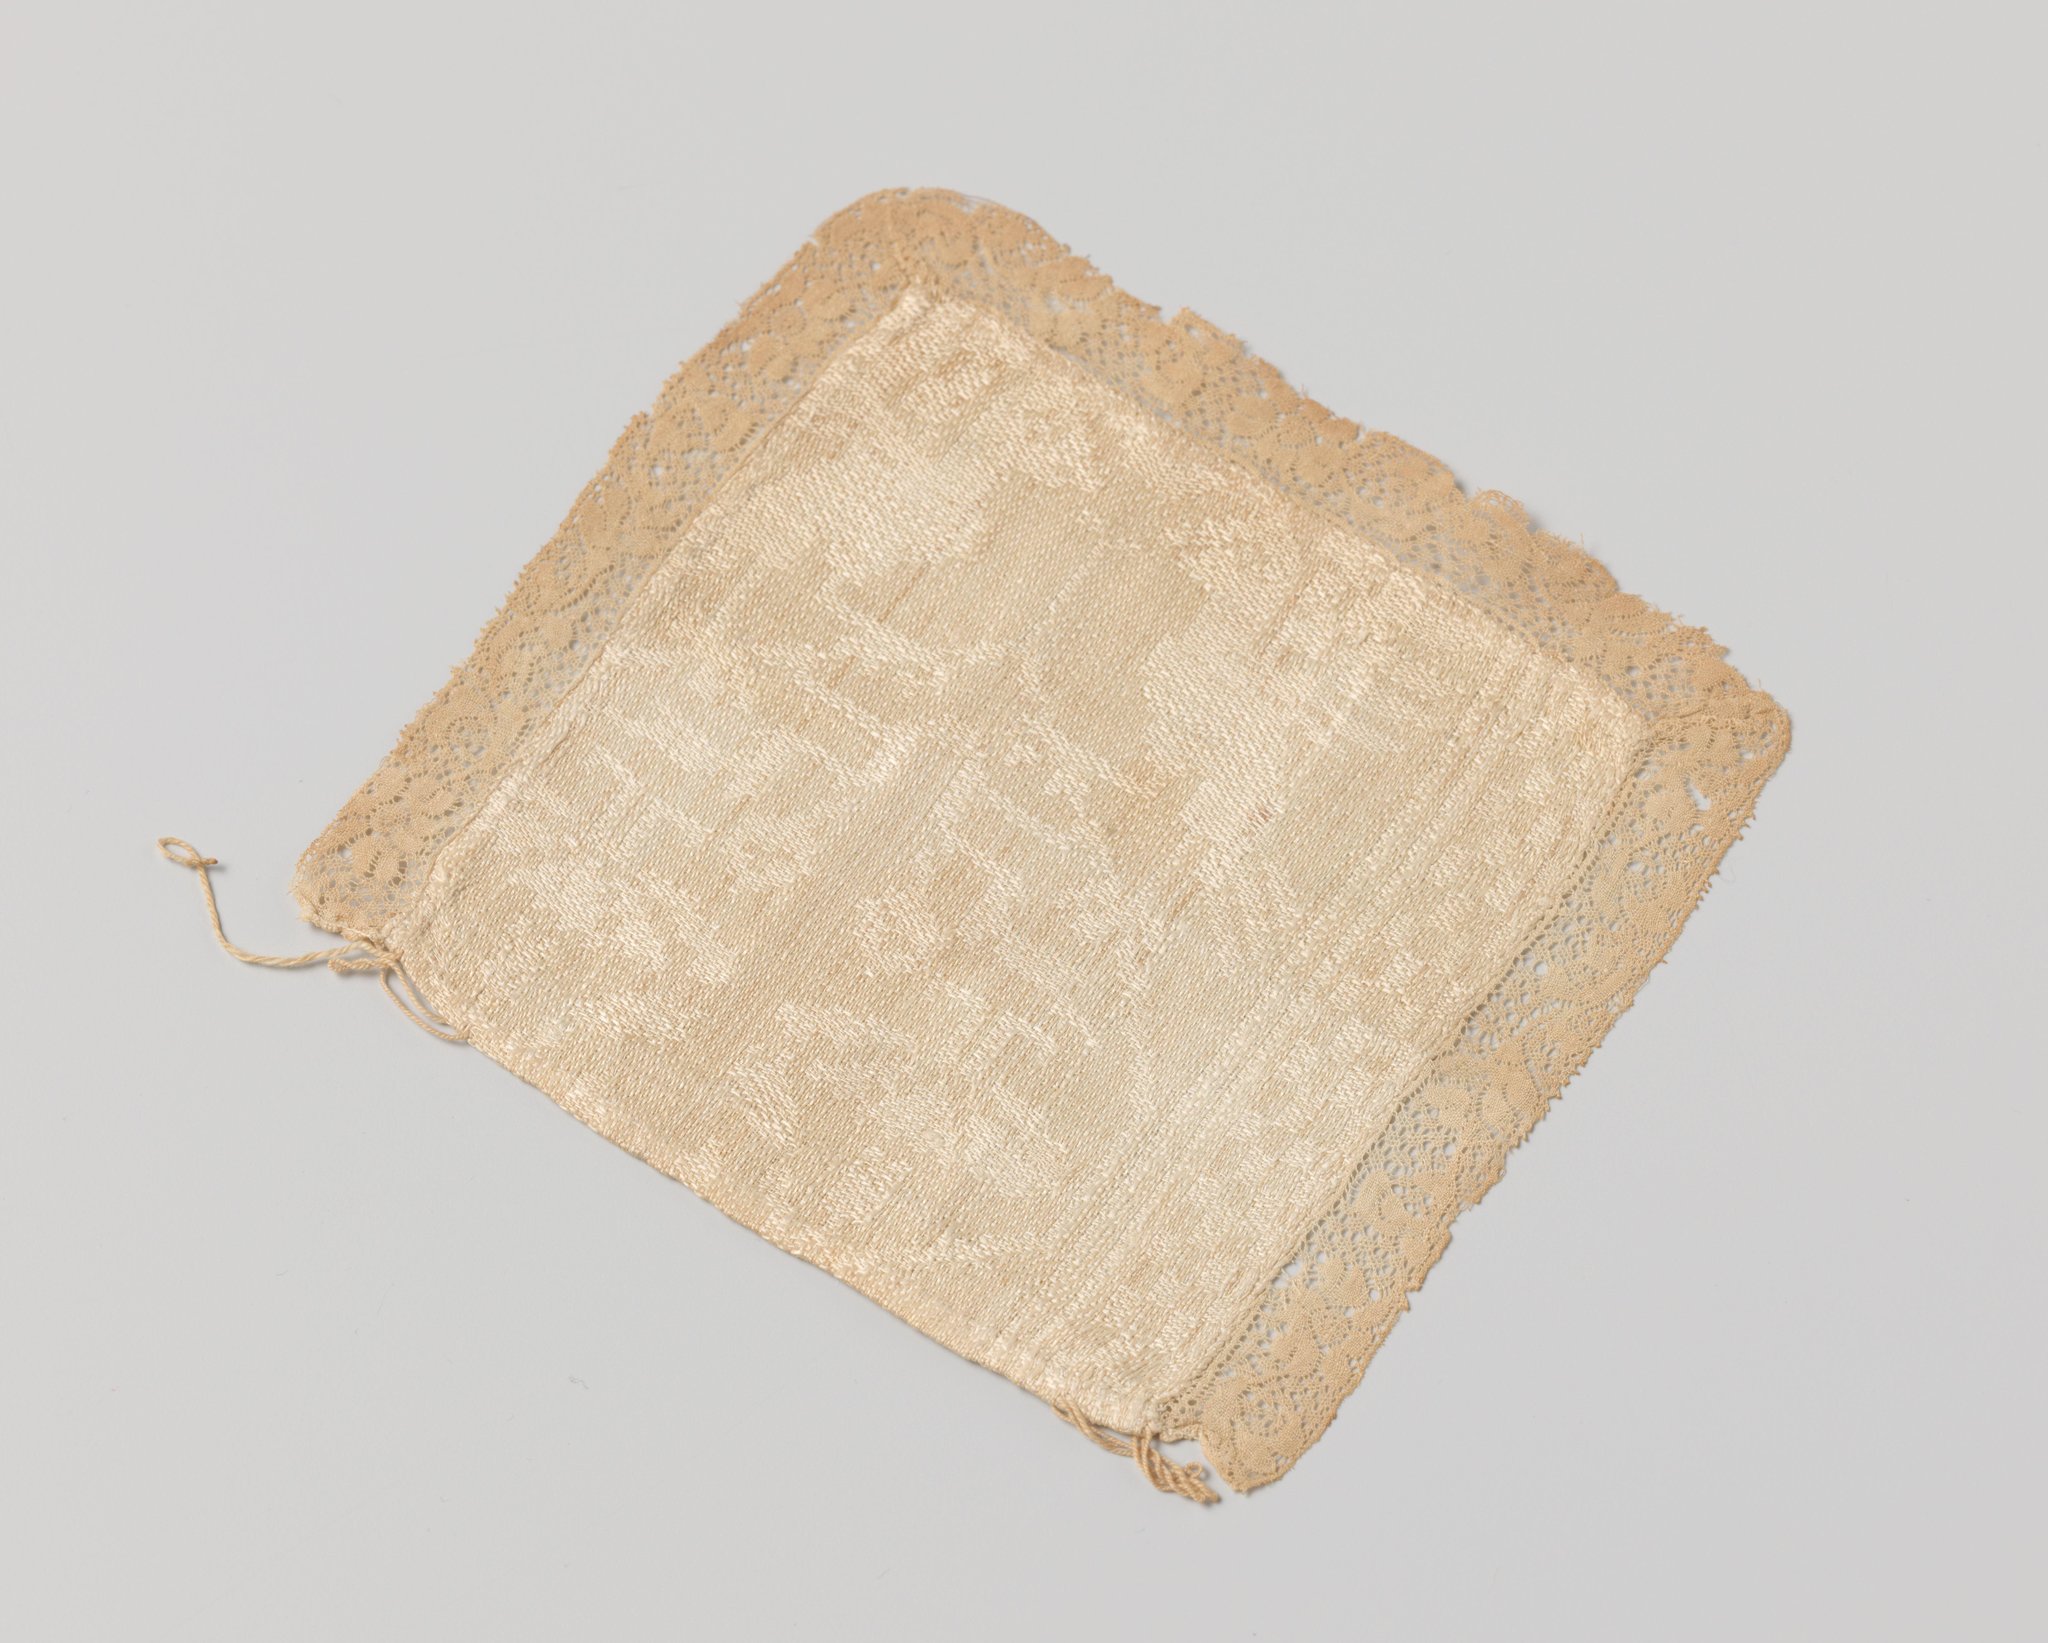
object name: kleed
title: Kleed met kant omzoomd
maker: Anonymous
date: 1675-1700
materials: linen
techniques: lace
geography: netherlands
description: Een kleed van linnen met damastpatroon; aan drie zijden afgezet met vlaams linnen kloskant, aan één zijde omzoomd en voorzien van twee lussen (één uitgerafeld).